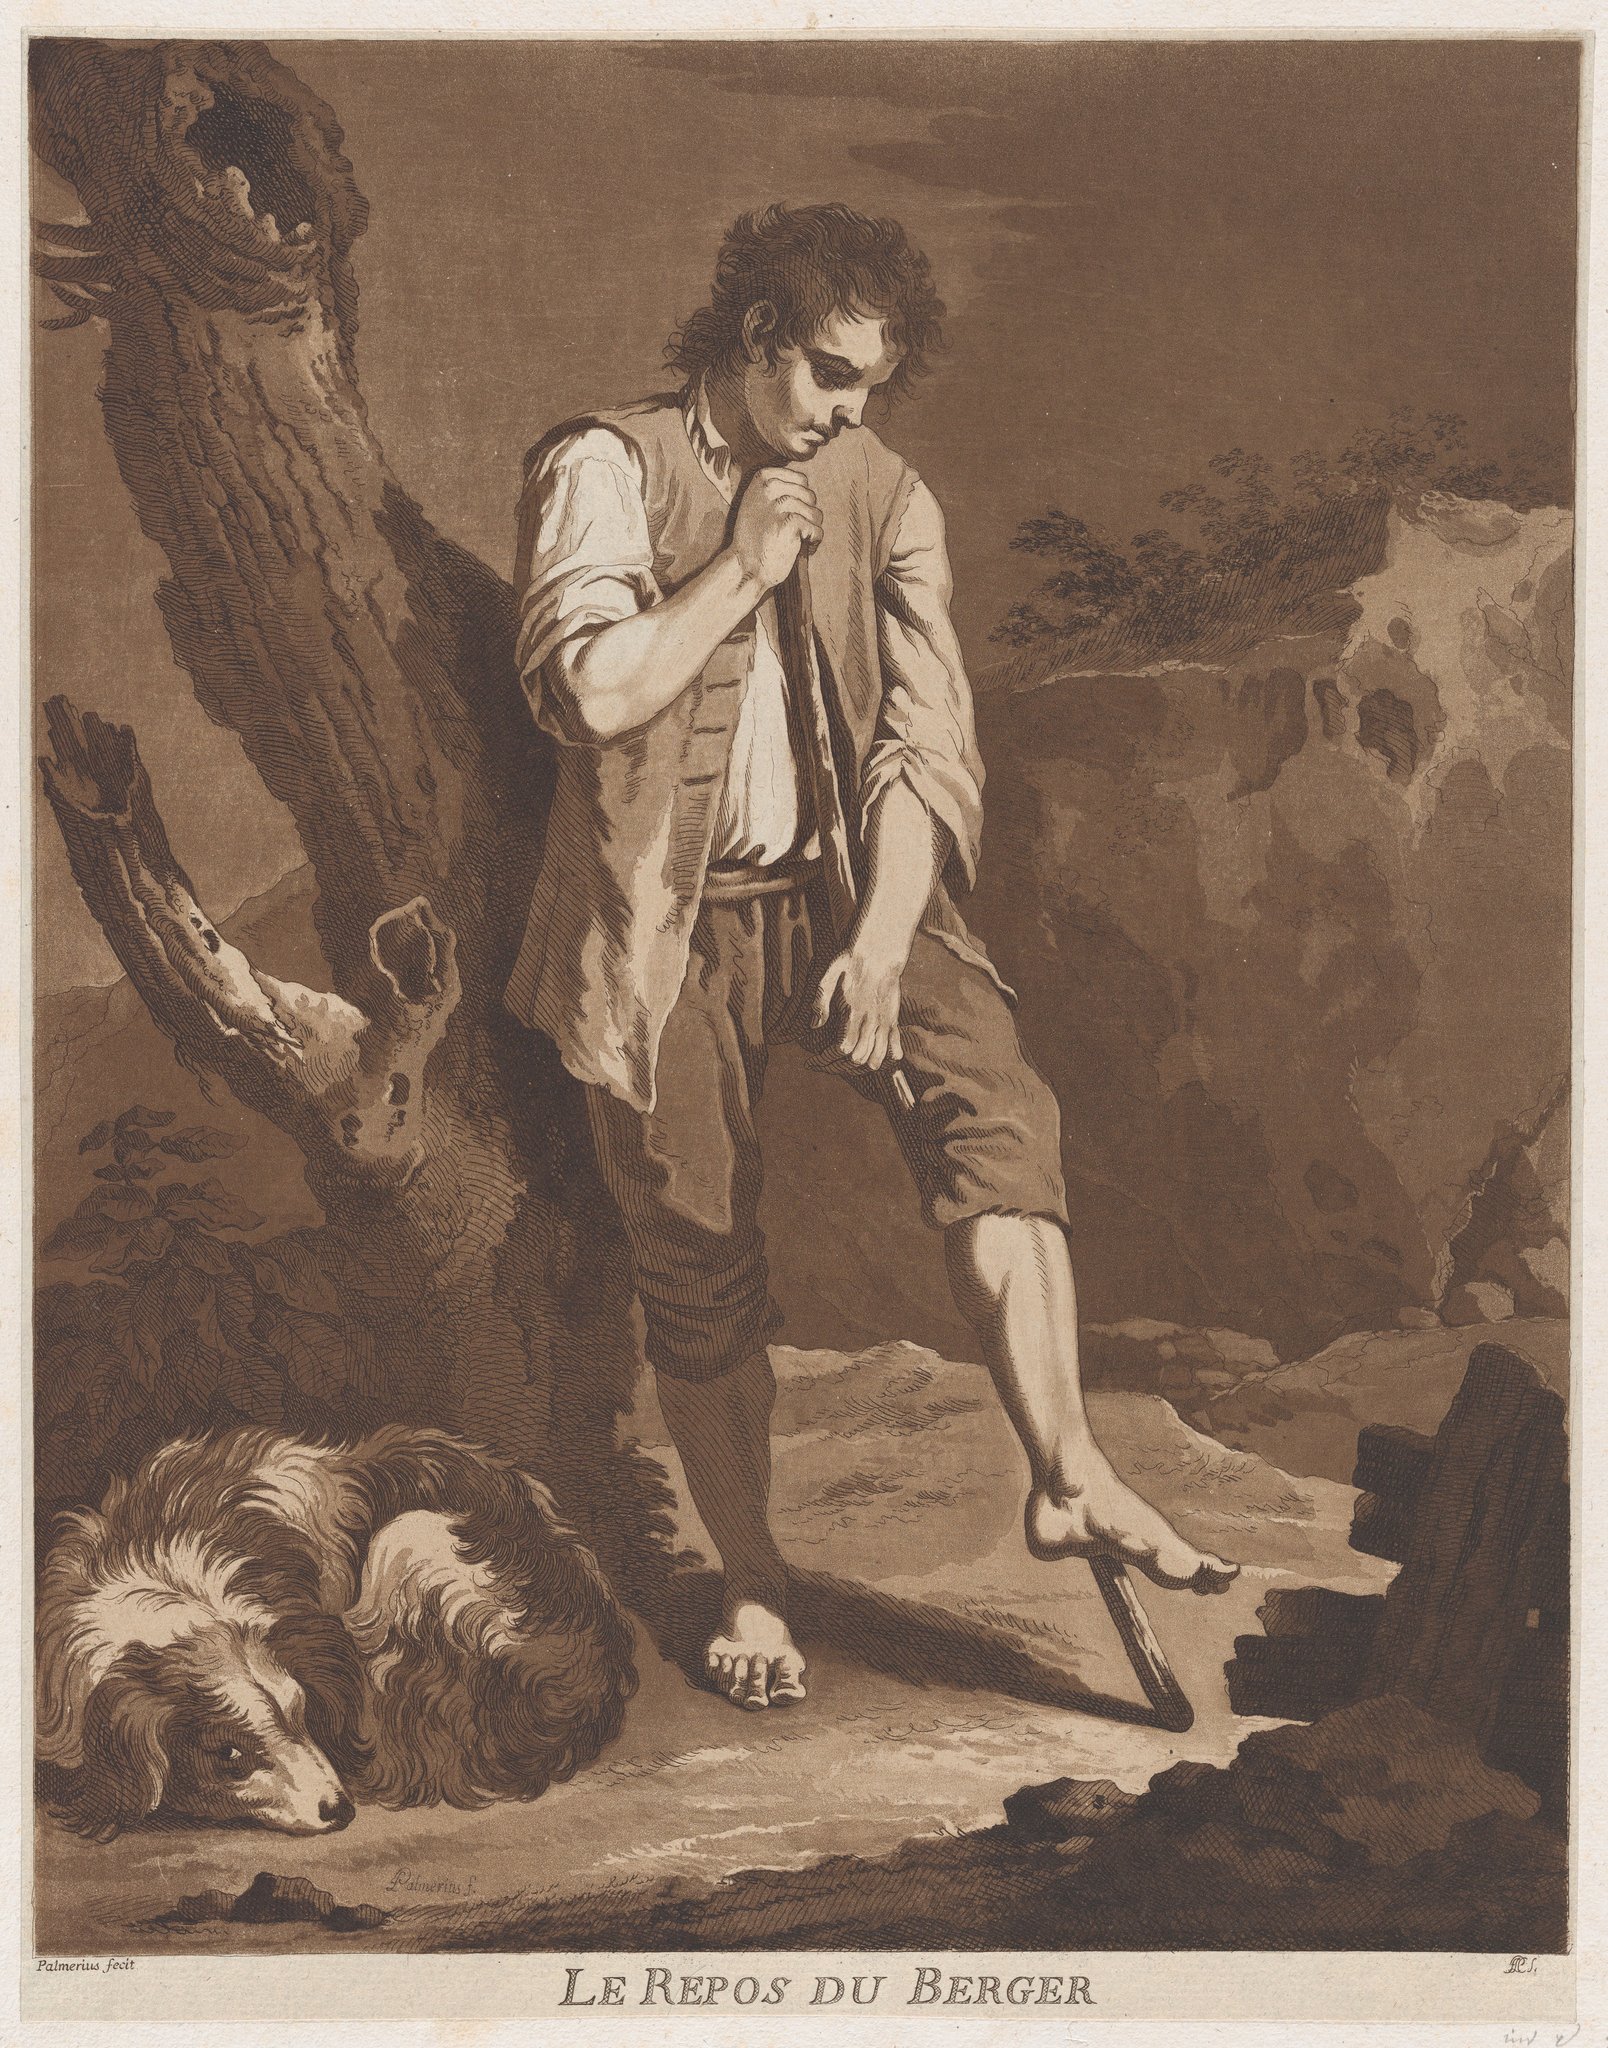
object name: print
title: The Shepherds Rest; a young man resting on a stick while his dog lies at his feet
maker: pietro jacopo palmieri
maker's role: artist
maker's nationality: italian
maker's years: 1737-1804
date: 1757-1804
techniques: aquatint, etching, printing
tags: men,dogs,shepherds